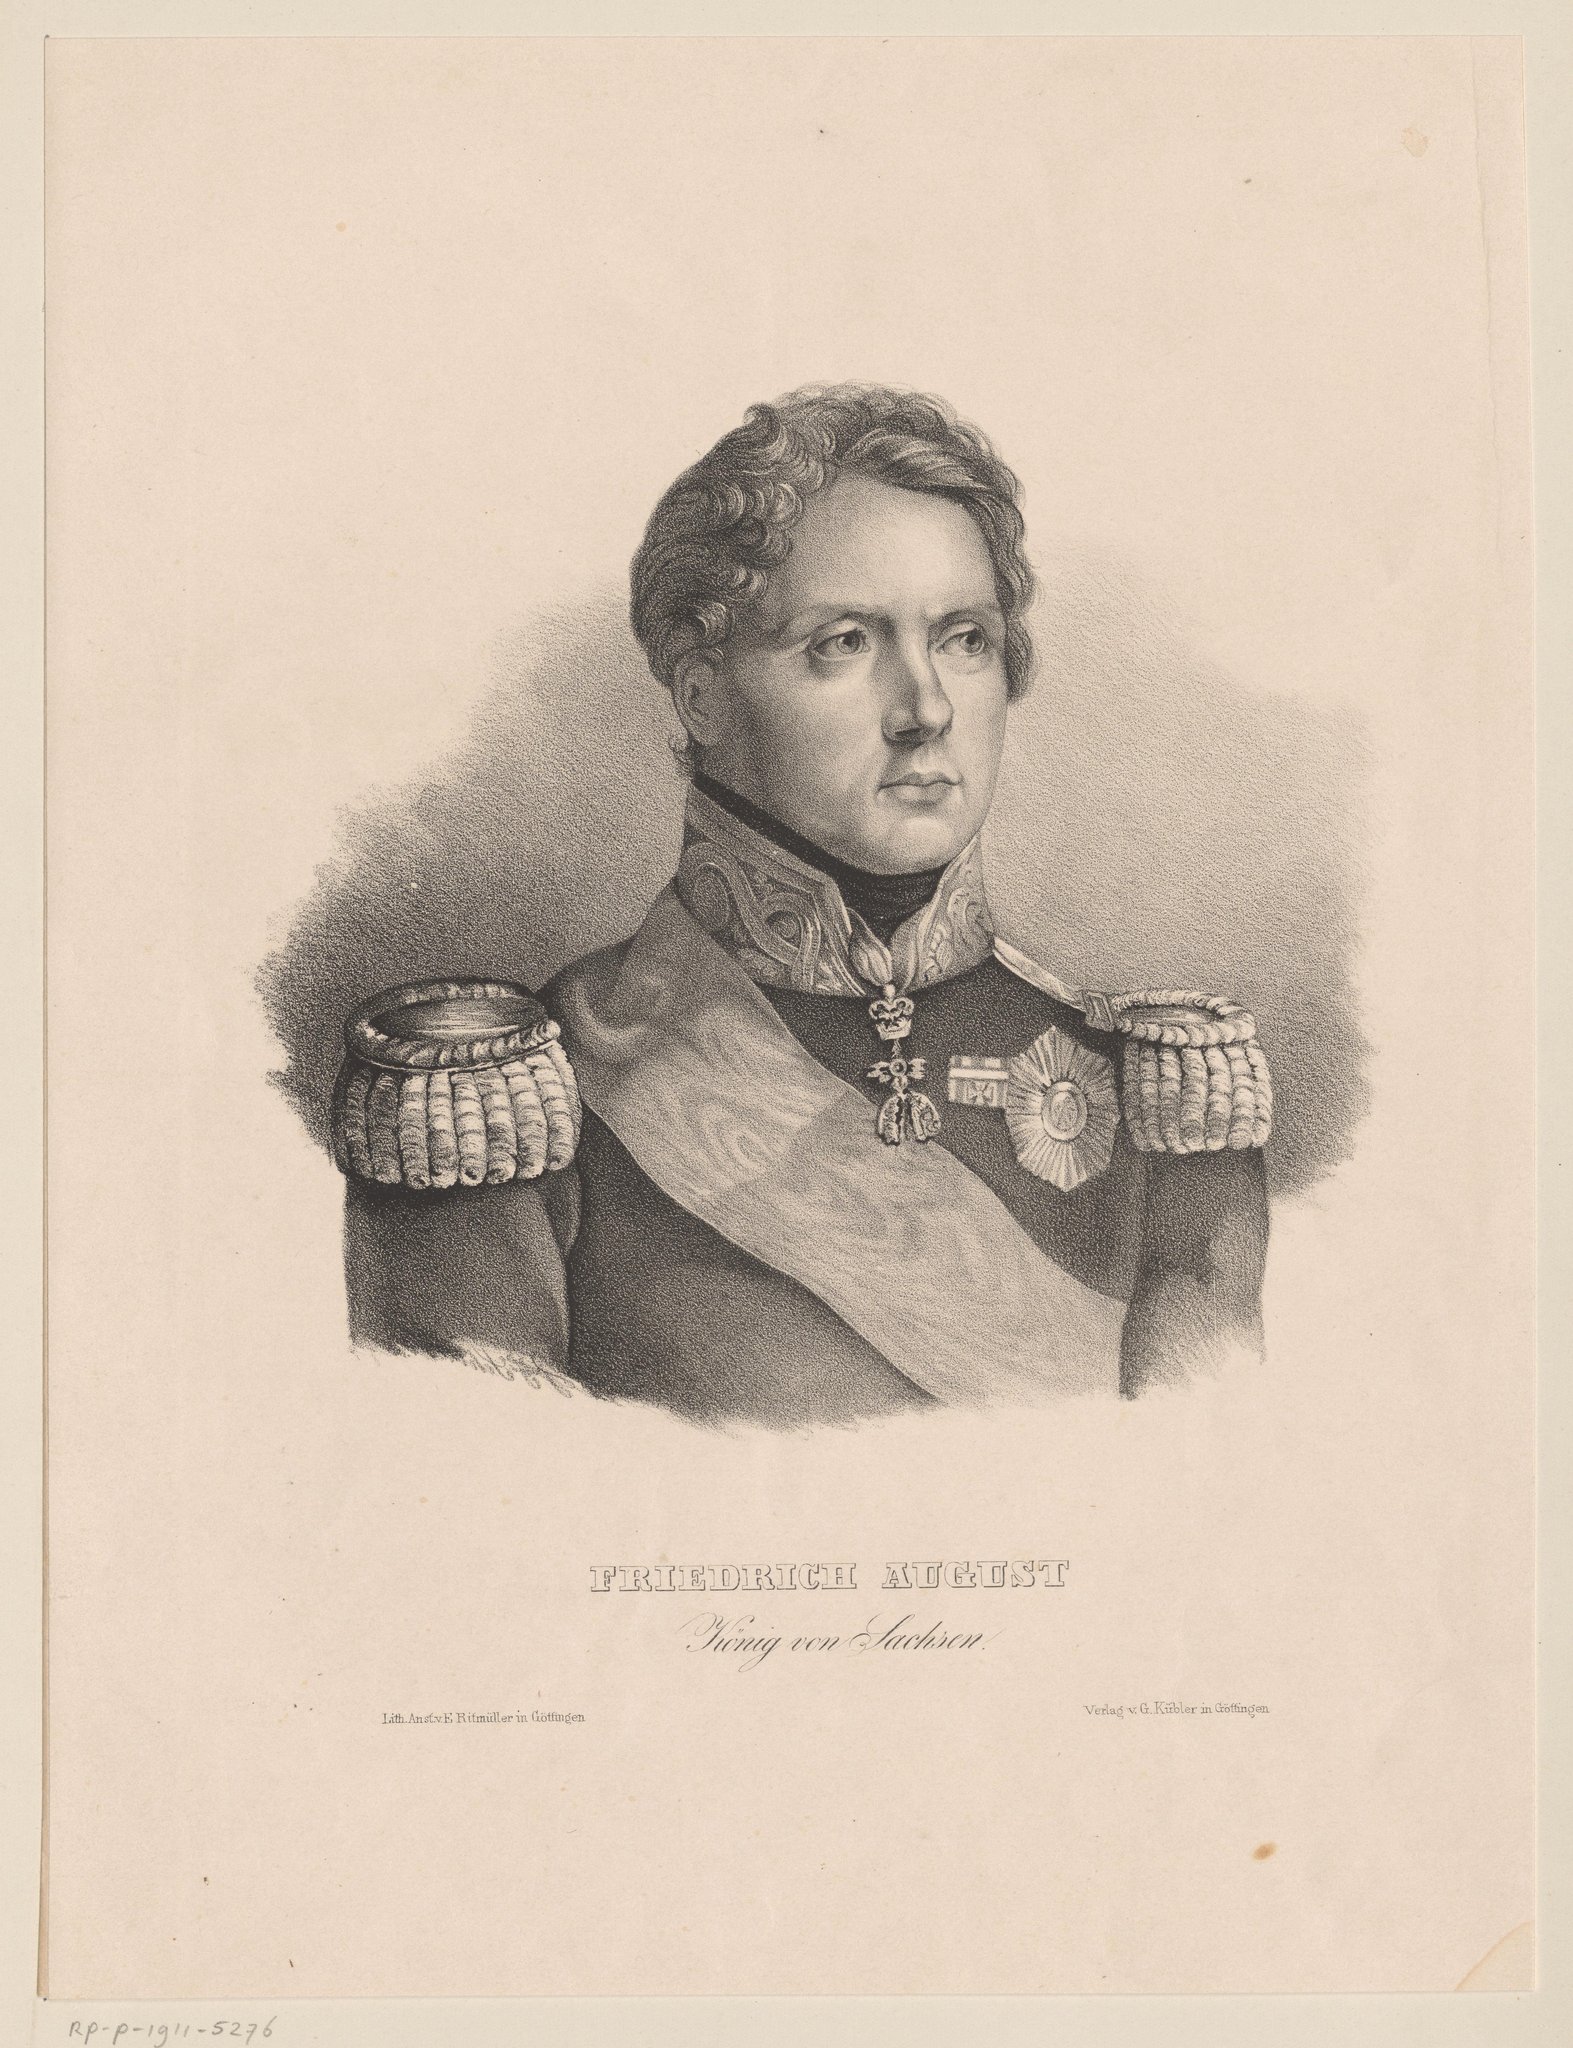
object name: print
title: Portret van Frederik August II van Saksen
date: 1836-1868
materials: paper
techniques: lithograph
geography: germany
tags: historical persons, knighthood order of the golden fleece, (military) uniforms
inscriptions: collector's mark: Lugt 2228